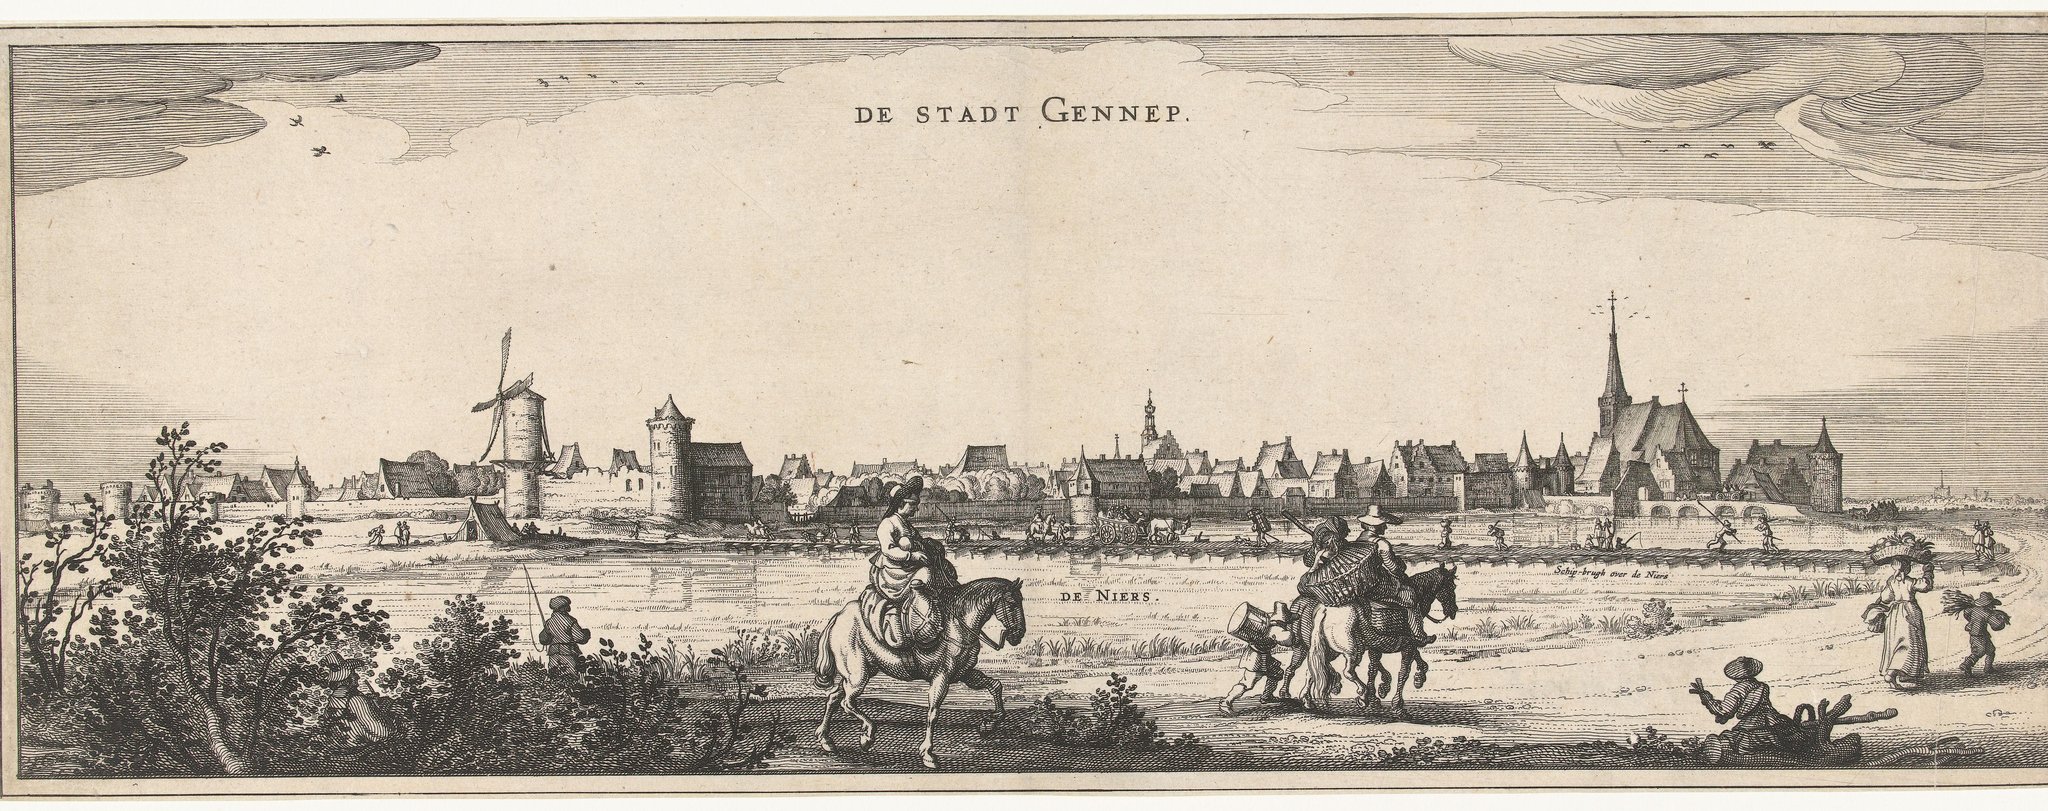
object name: print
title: Gezicht op Gennep, 1641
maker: claes jansz. visscher (ii)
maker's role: draughtsman, print maker, publisher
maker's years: 1586-1652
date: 1641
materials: paper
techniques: etching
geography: amsterdam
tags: delft, the hague, frederick henry (prince of orange)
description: Beleg en verovering van Gennep en het Huis te Gennep door het Staatse leger onder Frederik Hendrik, 6 juni - 27 juli 1641. Gezicht op de stad Gennep, op de voorgrond voorbijgangers op weg naar de stad over de schipbrug over de Niers. Van achteren onbedrukt. Bovenste helft van het versneden oorspronkelijke blad met twee voorstellingen.